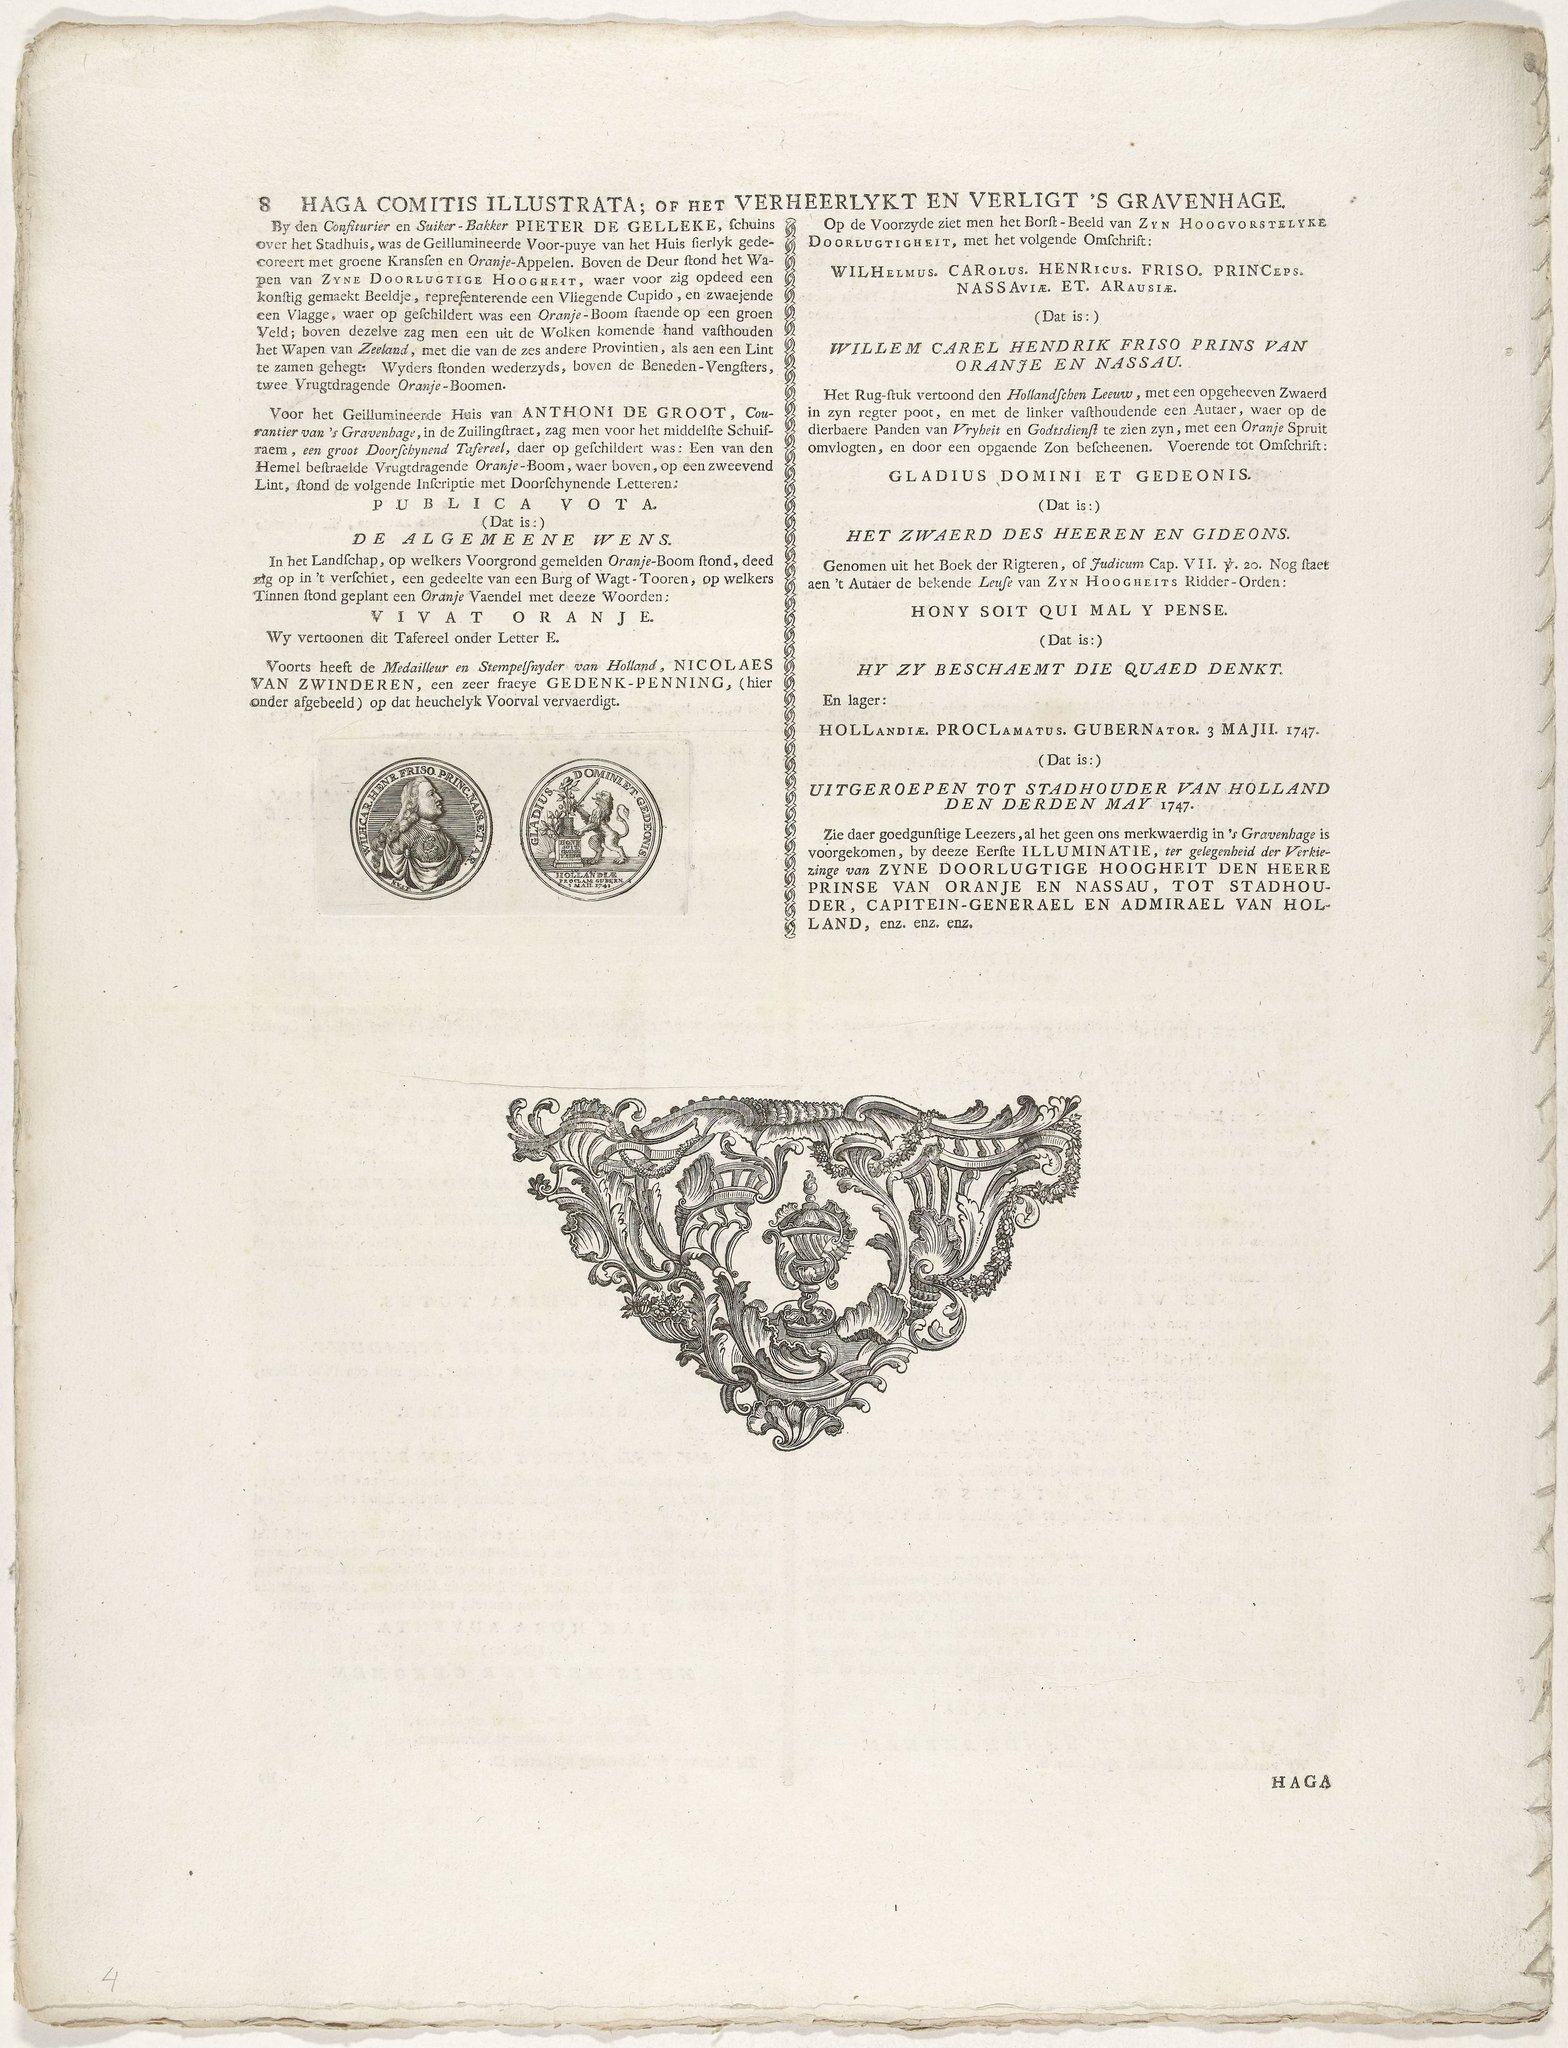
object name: text sheet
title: Haga comitis illustrata; of het verheerlykt en verligt 's Gravenhage bestaende in eene (...) verzameling van 116 (...) in het koper gebragte afbeeldingen, der (...) geillumineerd geweest zynde decoratien en zinnebeelden (...) ter geleegenheid der (...) verkiezinge, proclamatie & installatie van Z.D.H. Willem Carel Hendrik Friso, Prince van Oranje & Nassau, enz. tot Stadhouder (...) den 3 & 15 May 1747 : opgehelderd door een (...) beschryving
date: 1751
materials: paper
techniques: etching, letterpress printing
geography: the hague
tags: willem iv (prins van oranje-nassau), medal (considered as a piece of sculpture, regardless of its specific function), the hague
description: Laatste tekstblad in het eerste tekstdeel met tekst in twee kolommen, een voorstelling van een penning op de stadhouder en onderaan een vignet met een vaas tussen rocailles. Los blad oorspronkelijk onderdeel van het plaatwerk Haga comitis illustrata uit 1751 met de versieringen opgesteld te Den Haag tijdens de feestelijkheden rond de installatie van prins Willem IV als stadhouder van Holland en West-Friesland op 3 en 15 mei 1747.